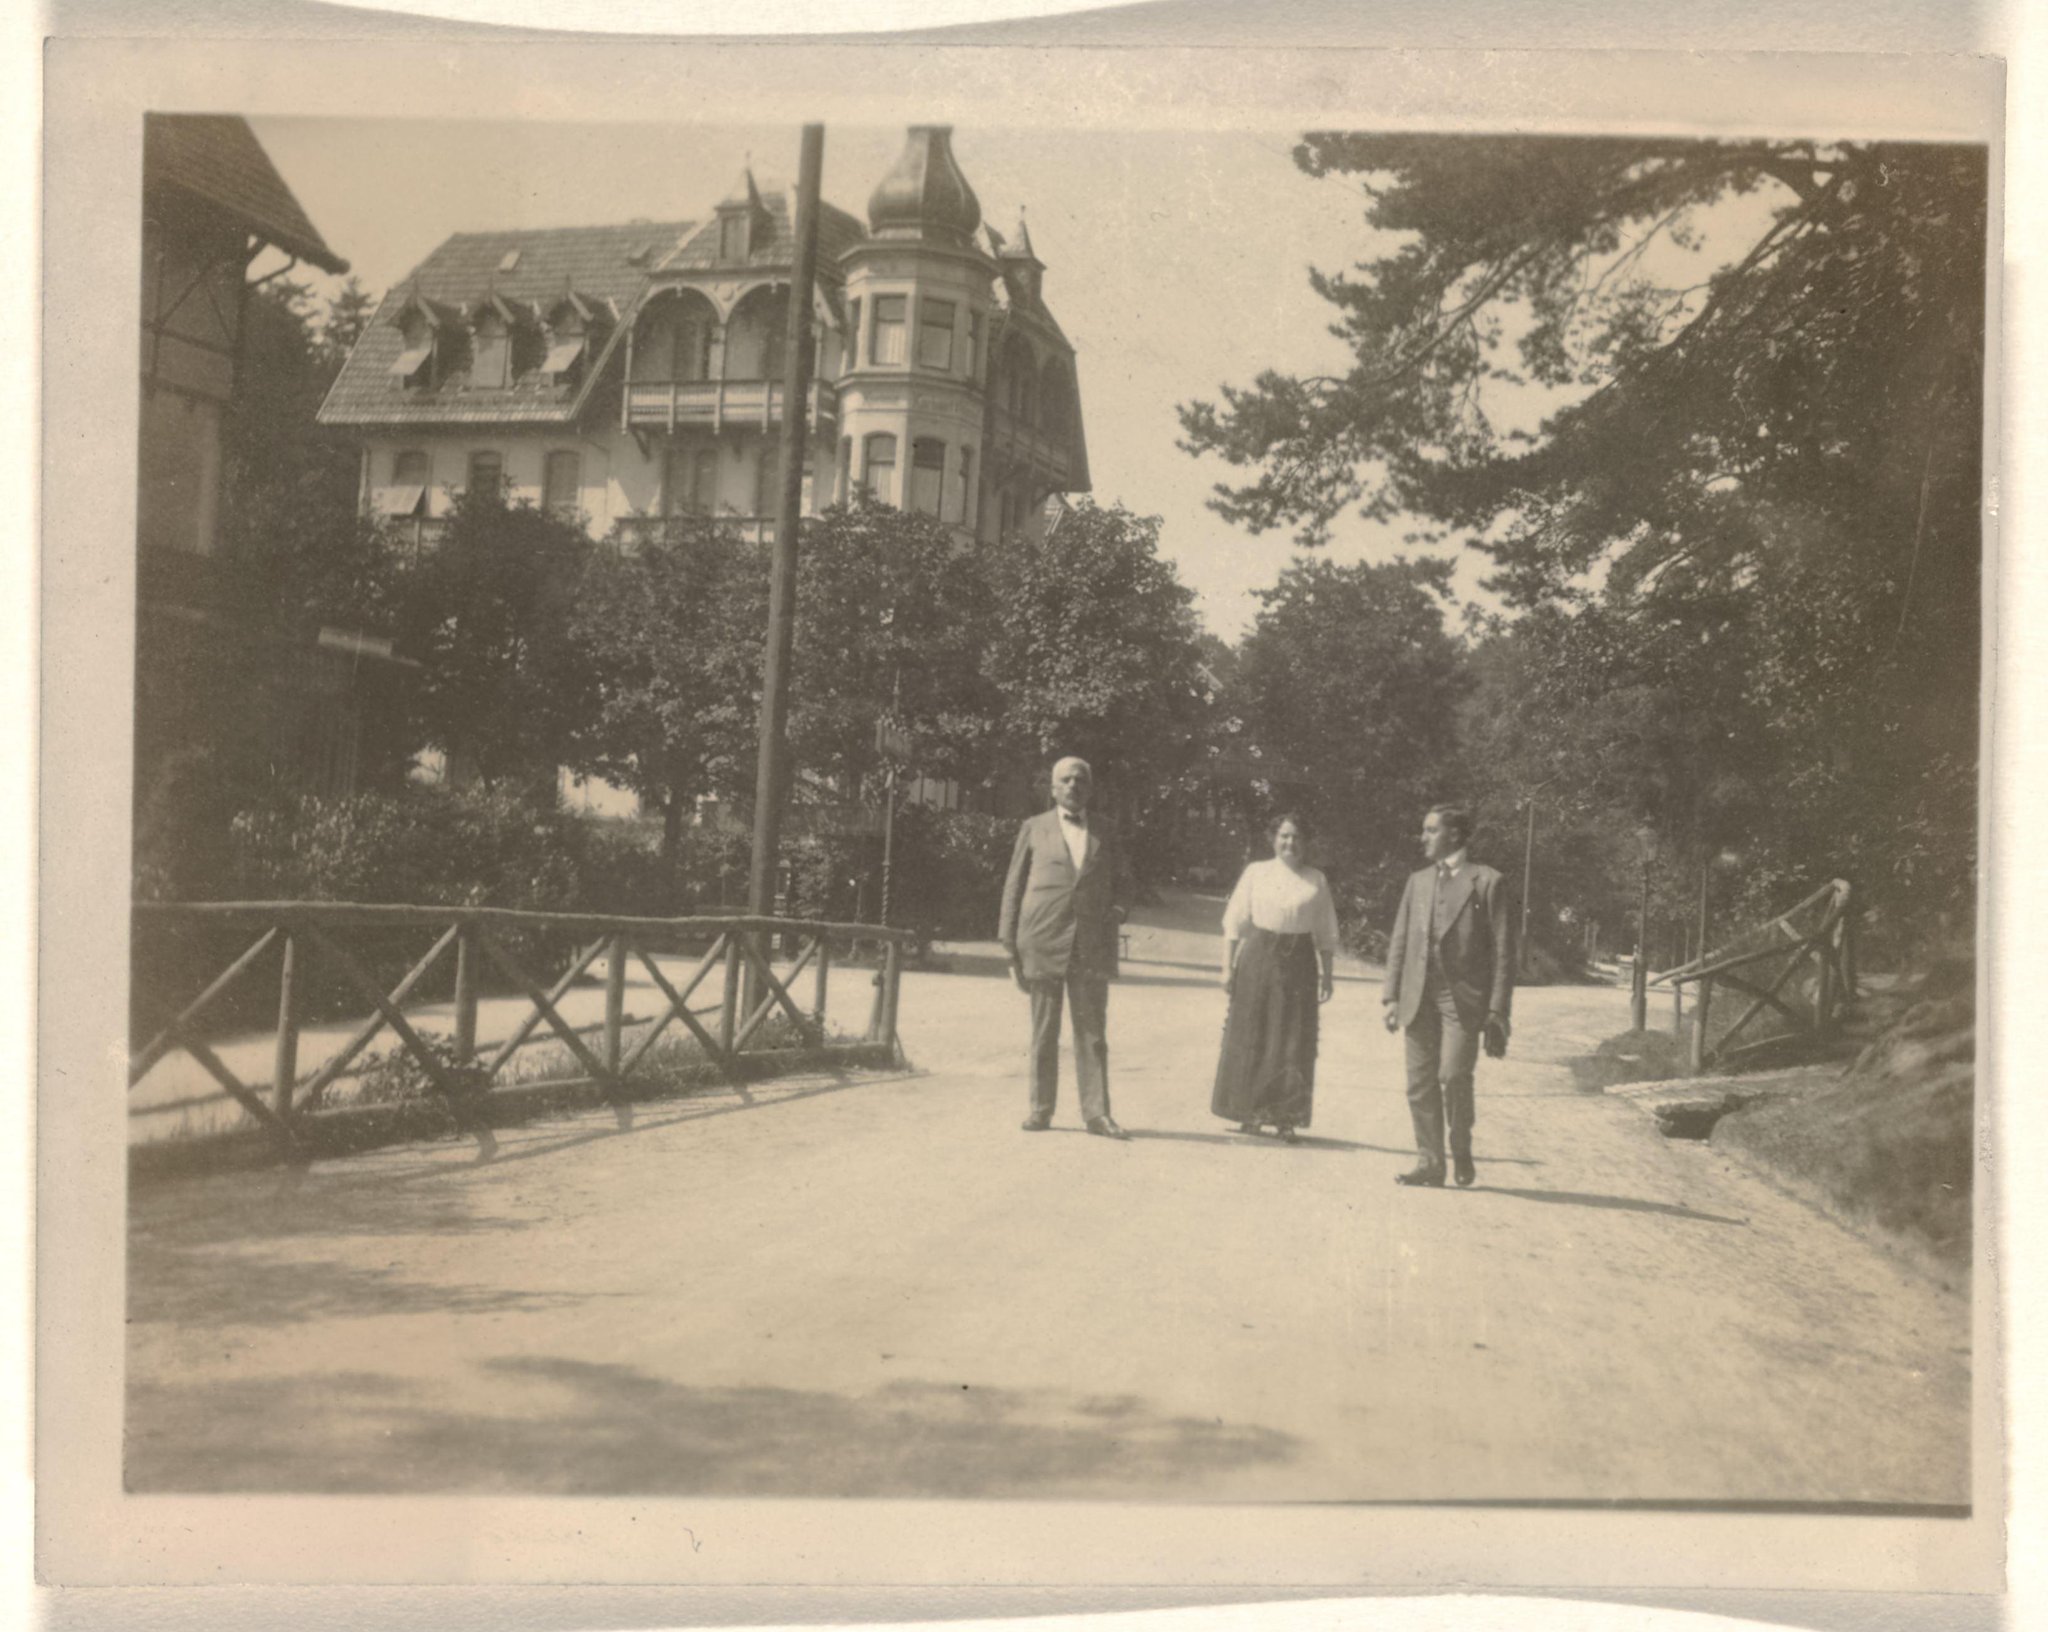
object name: photograph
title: Meir Wachenheimer, zijn echtgenote Mathilde Wachenheimer-Wertheimer en hun zoon Eugen Wachenheimer lopende op straat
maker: Anonymous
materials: photographic support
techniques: gelatin silver print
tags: eugen wachenheimer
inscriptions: number: ‘2’